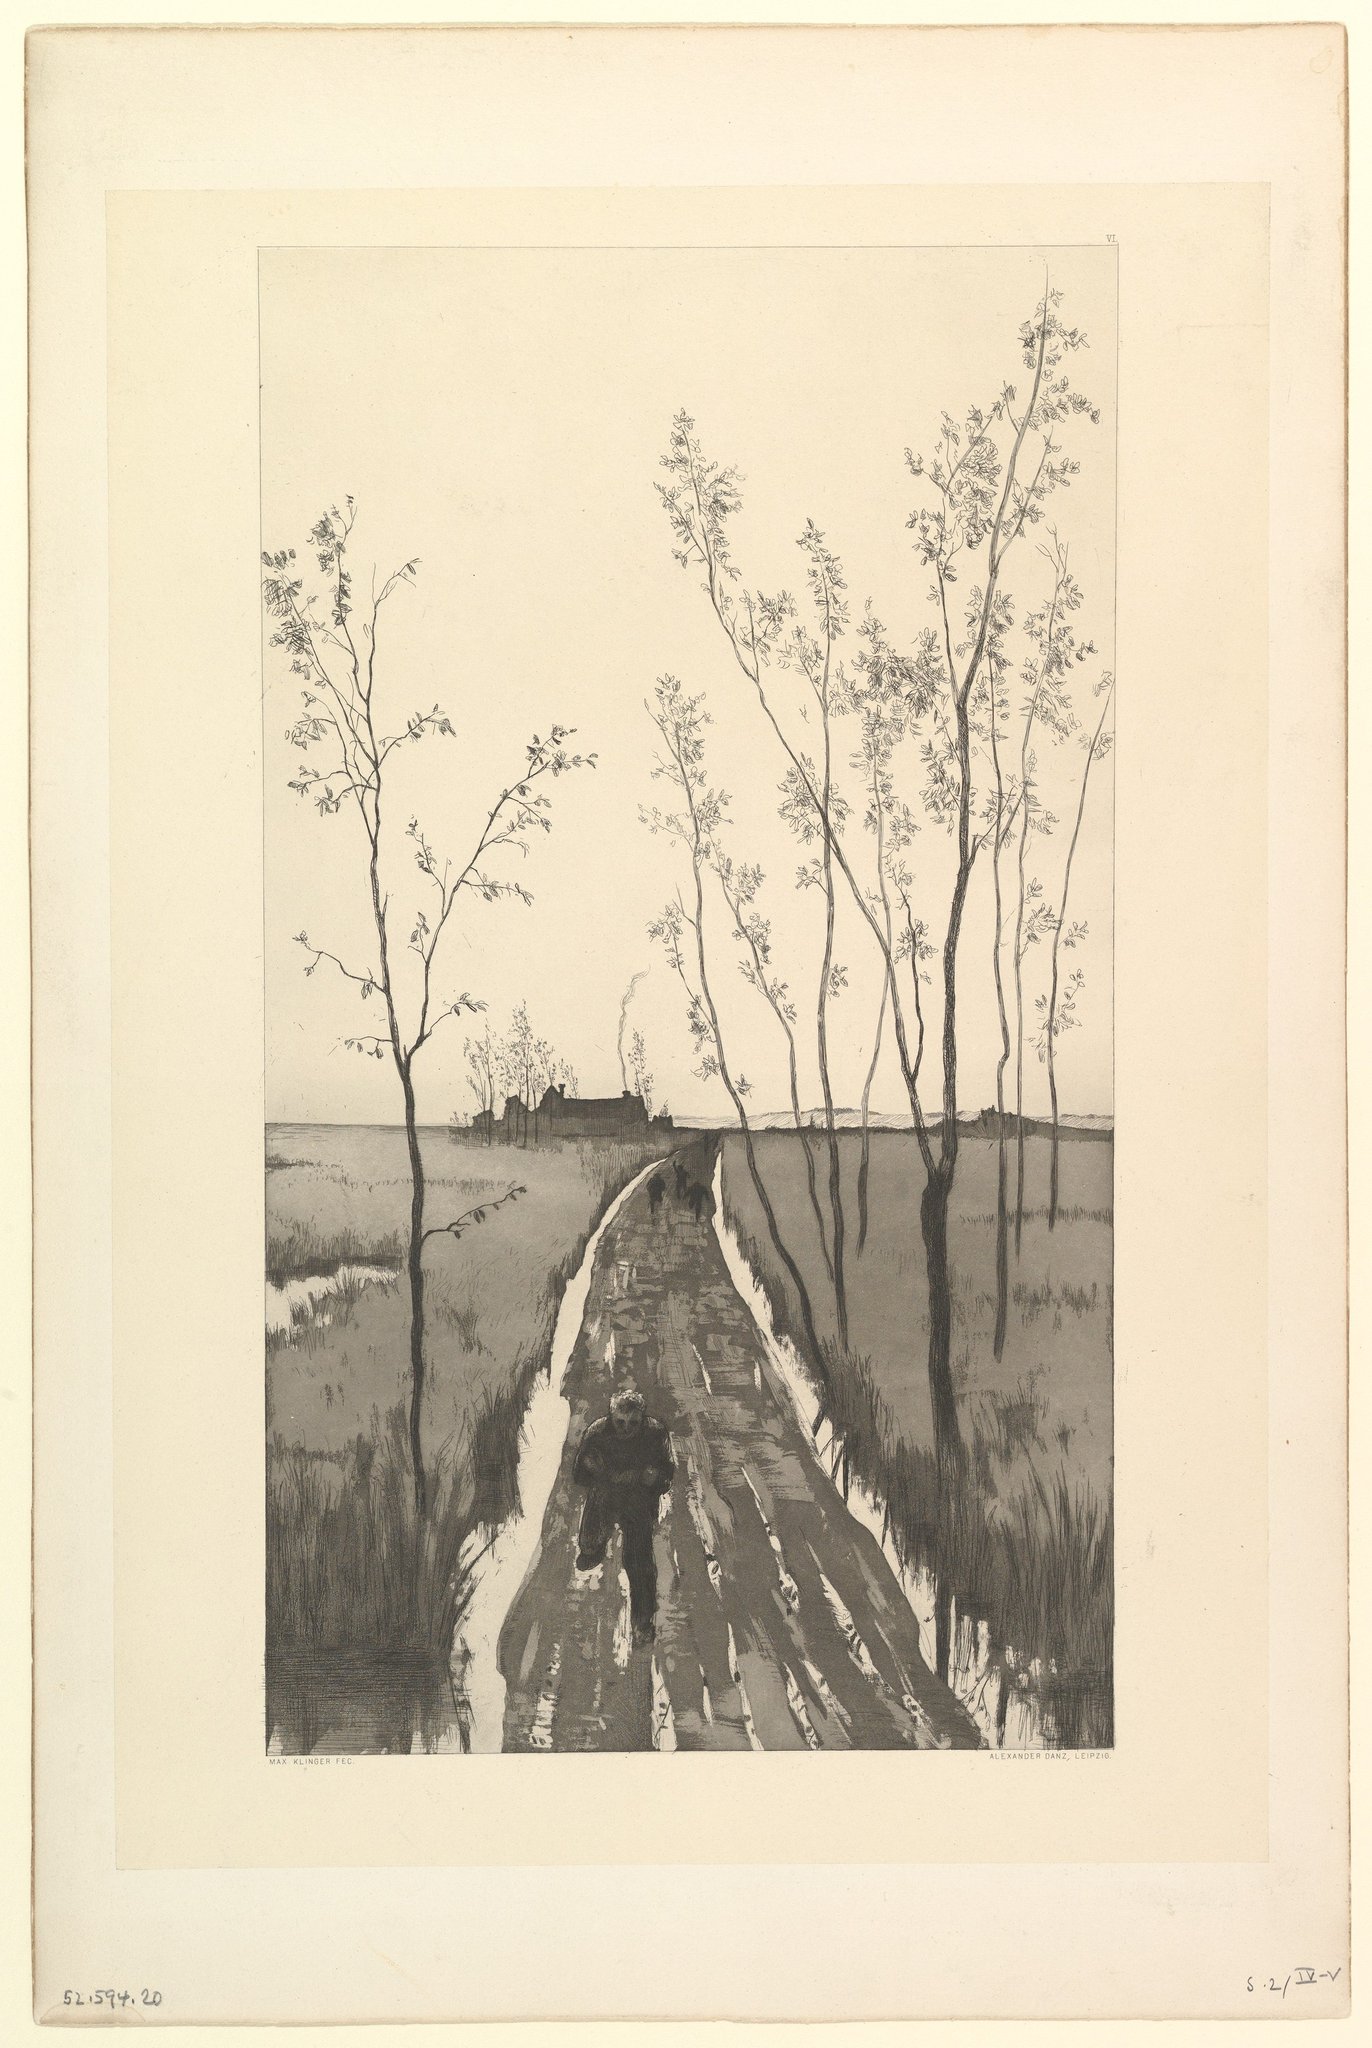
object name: print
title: Verfolgung, from the series Radierte Skizzen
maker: max klinger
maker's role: artist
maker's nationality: german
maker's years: 1857-1920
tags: human figures,roads,landscapes